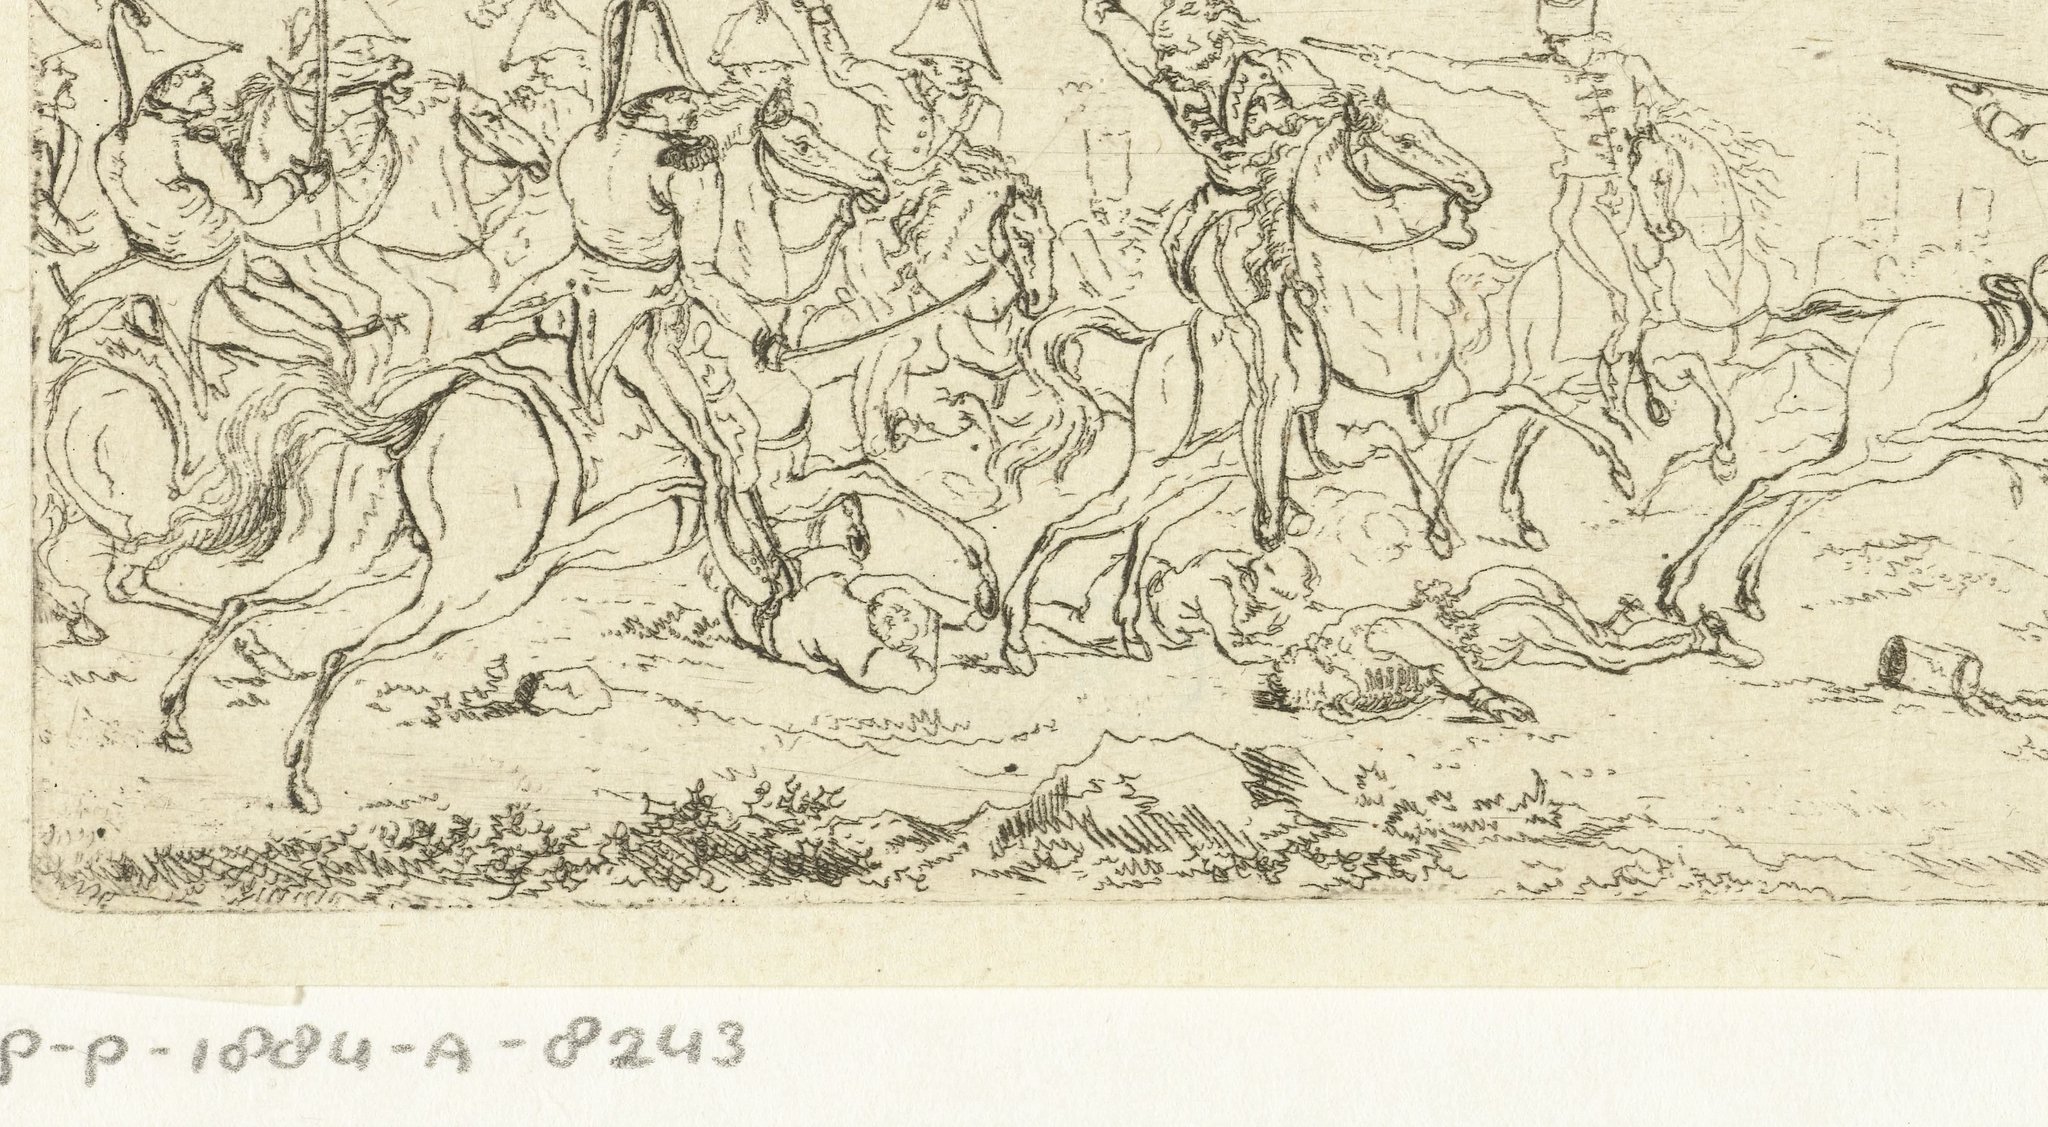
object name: print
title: Ruiterij schermutseling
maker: gerardus emaus de micault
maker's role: draughtsman, print maker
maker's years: 1798-1863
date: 1813-1863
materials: paper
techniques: etching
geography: netherlands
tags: warfare; military affairs (+ cavalry, horsemen)